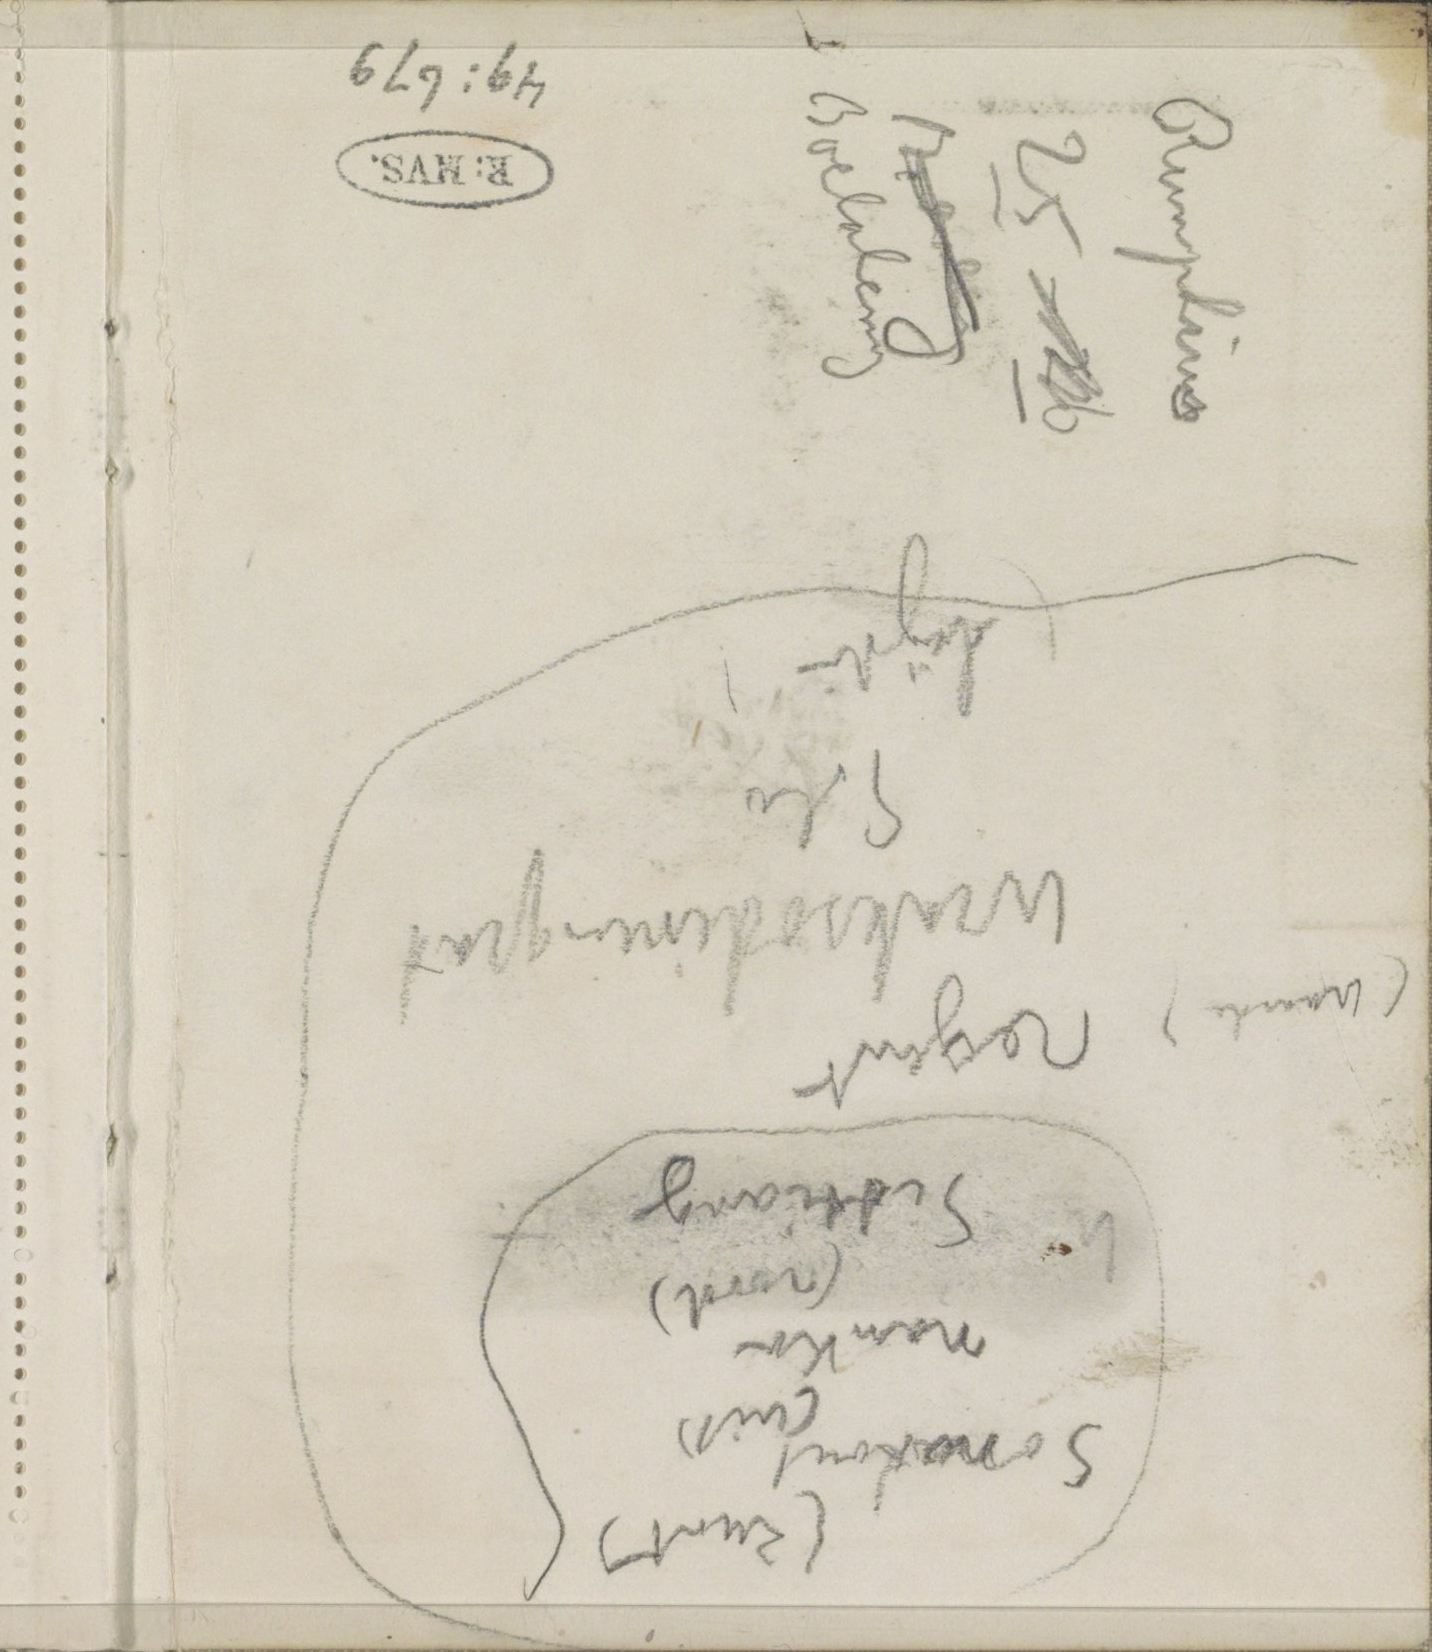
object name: endleaf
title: Annotaties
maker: marius bauer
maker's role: draughtsman, print maker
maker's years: 1867-1932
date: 1925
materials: paper, pencil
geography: indonesia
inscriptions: annotation: ‘zunt/ 5 ona[...]/ nan Ka/ (nord)/ Sidtiang/ [...] negent/ kraksodinengrat/ [...]/ Rumphin[...]/ 25/ Boekaleng’, collector's mark: Lugt 2228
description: Achterste schutblad uit een schetsboek met 67 bladen.